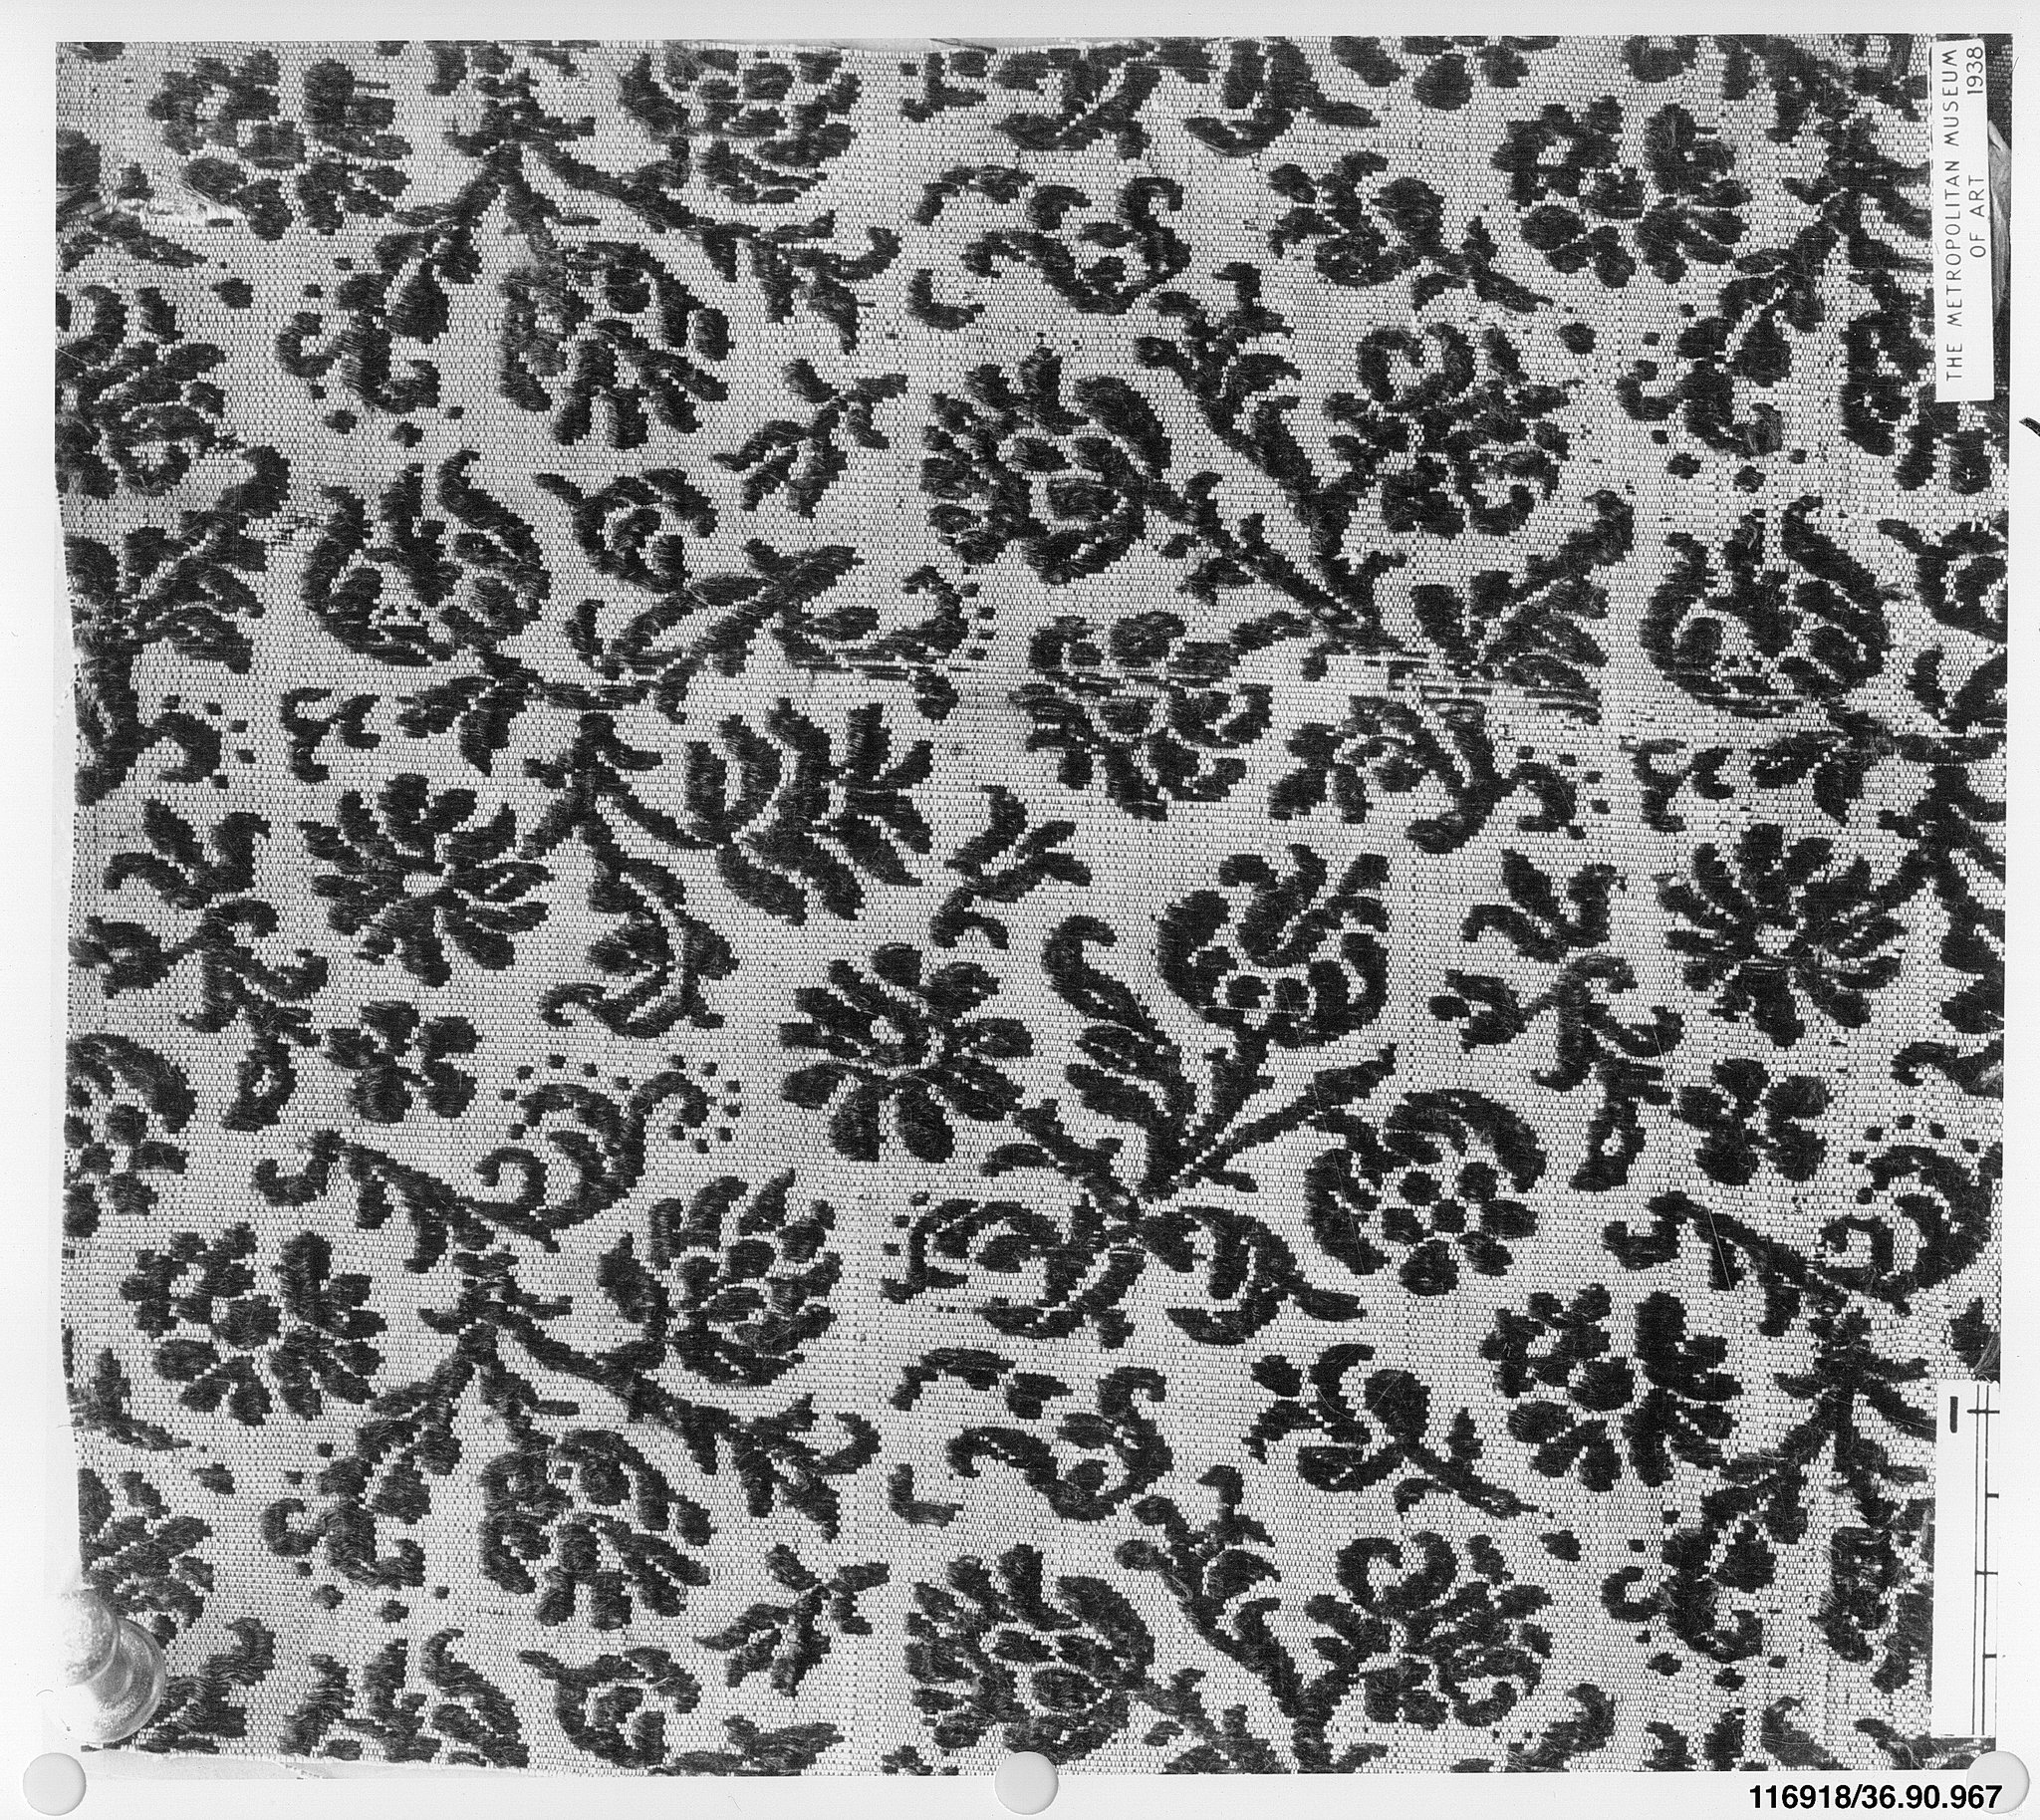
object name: piece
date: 1601-1700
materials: silk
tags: flowers,leaves